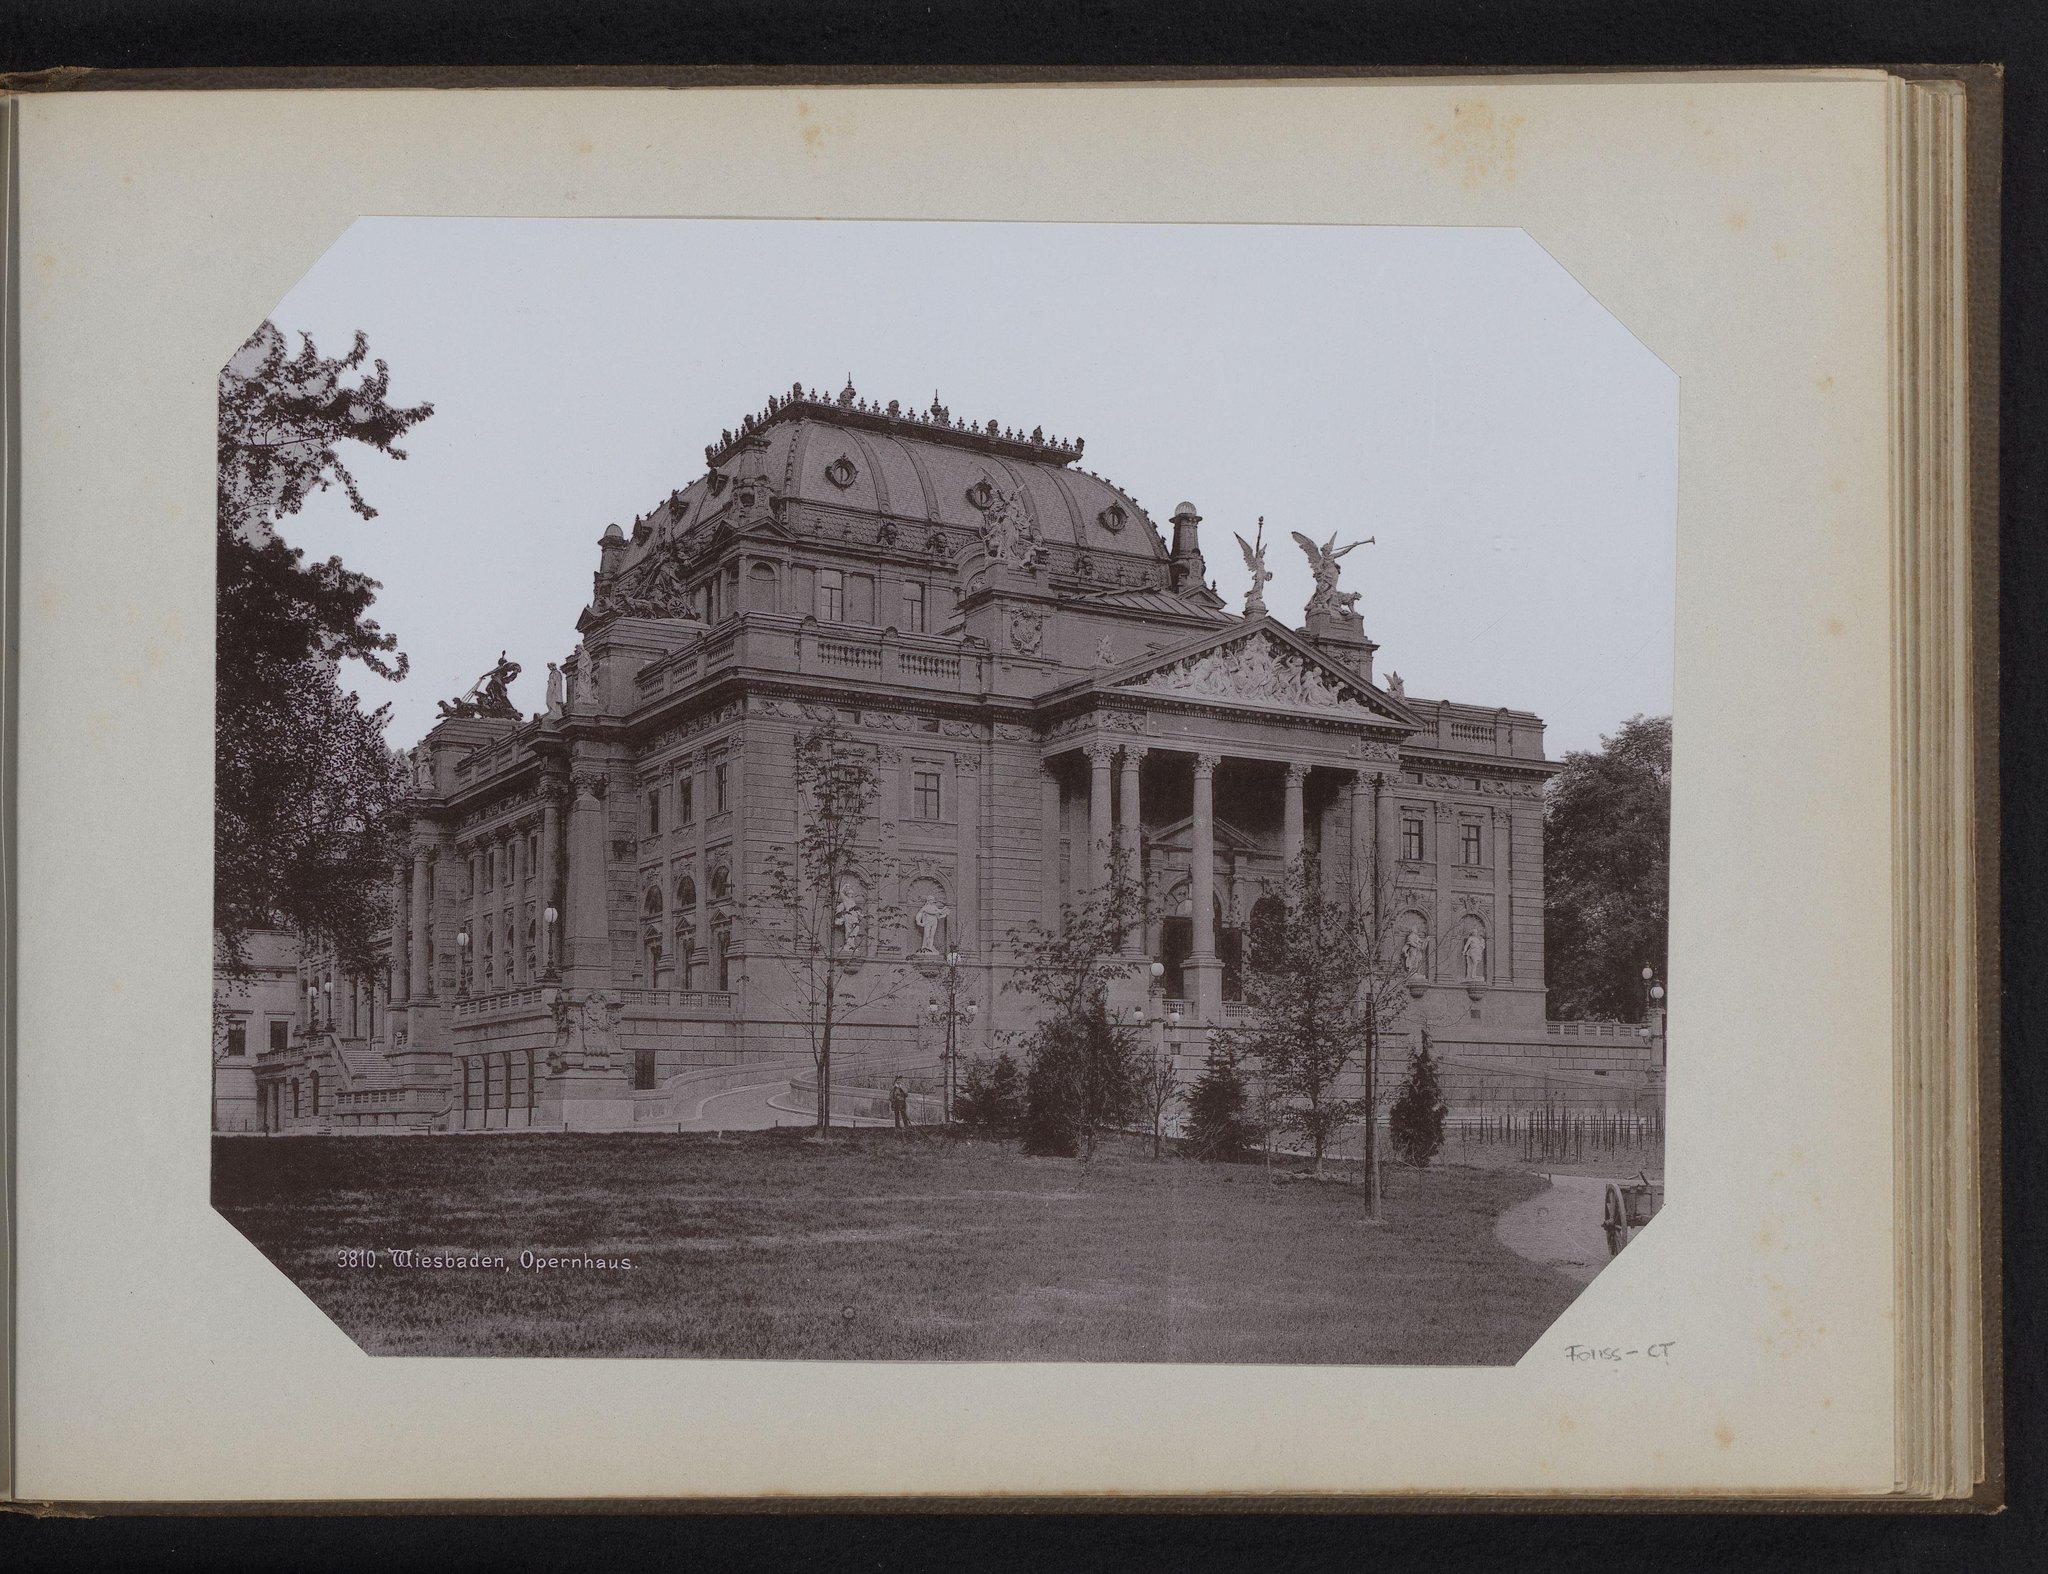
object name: photomechanical print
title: Gezicht op het operahuis te Wiesbaden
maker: Anonymous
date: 1890-1899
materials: paper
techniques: photograph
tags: opera house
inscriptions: inscription: ‘3810. Wiesbaden, Opernhaus.’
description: Deze prent maakt deel uit van een album.